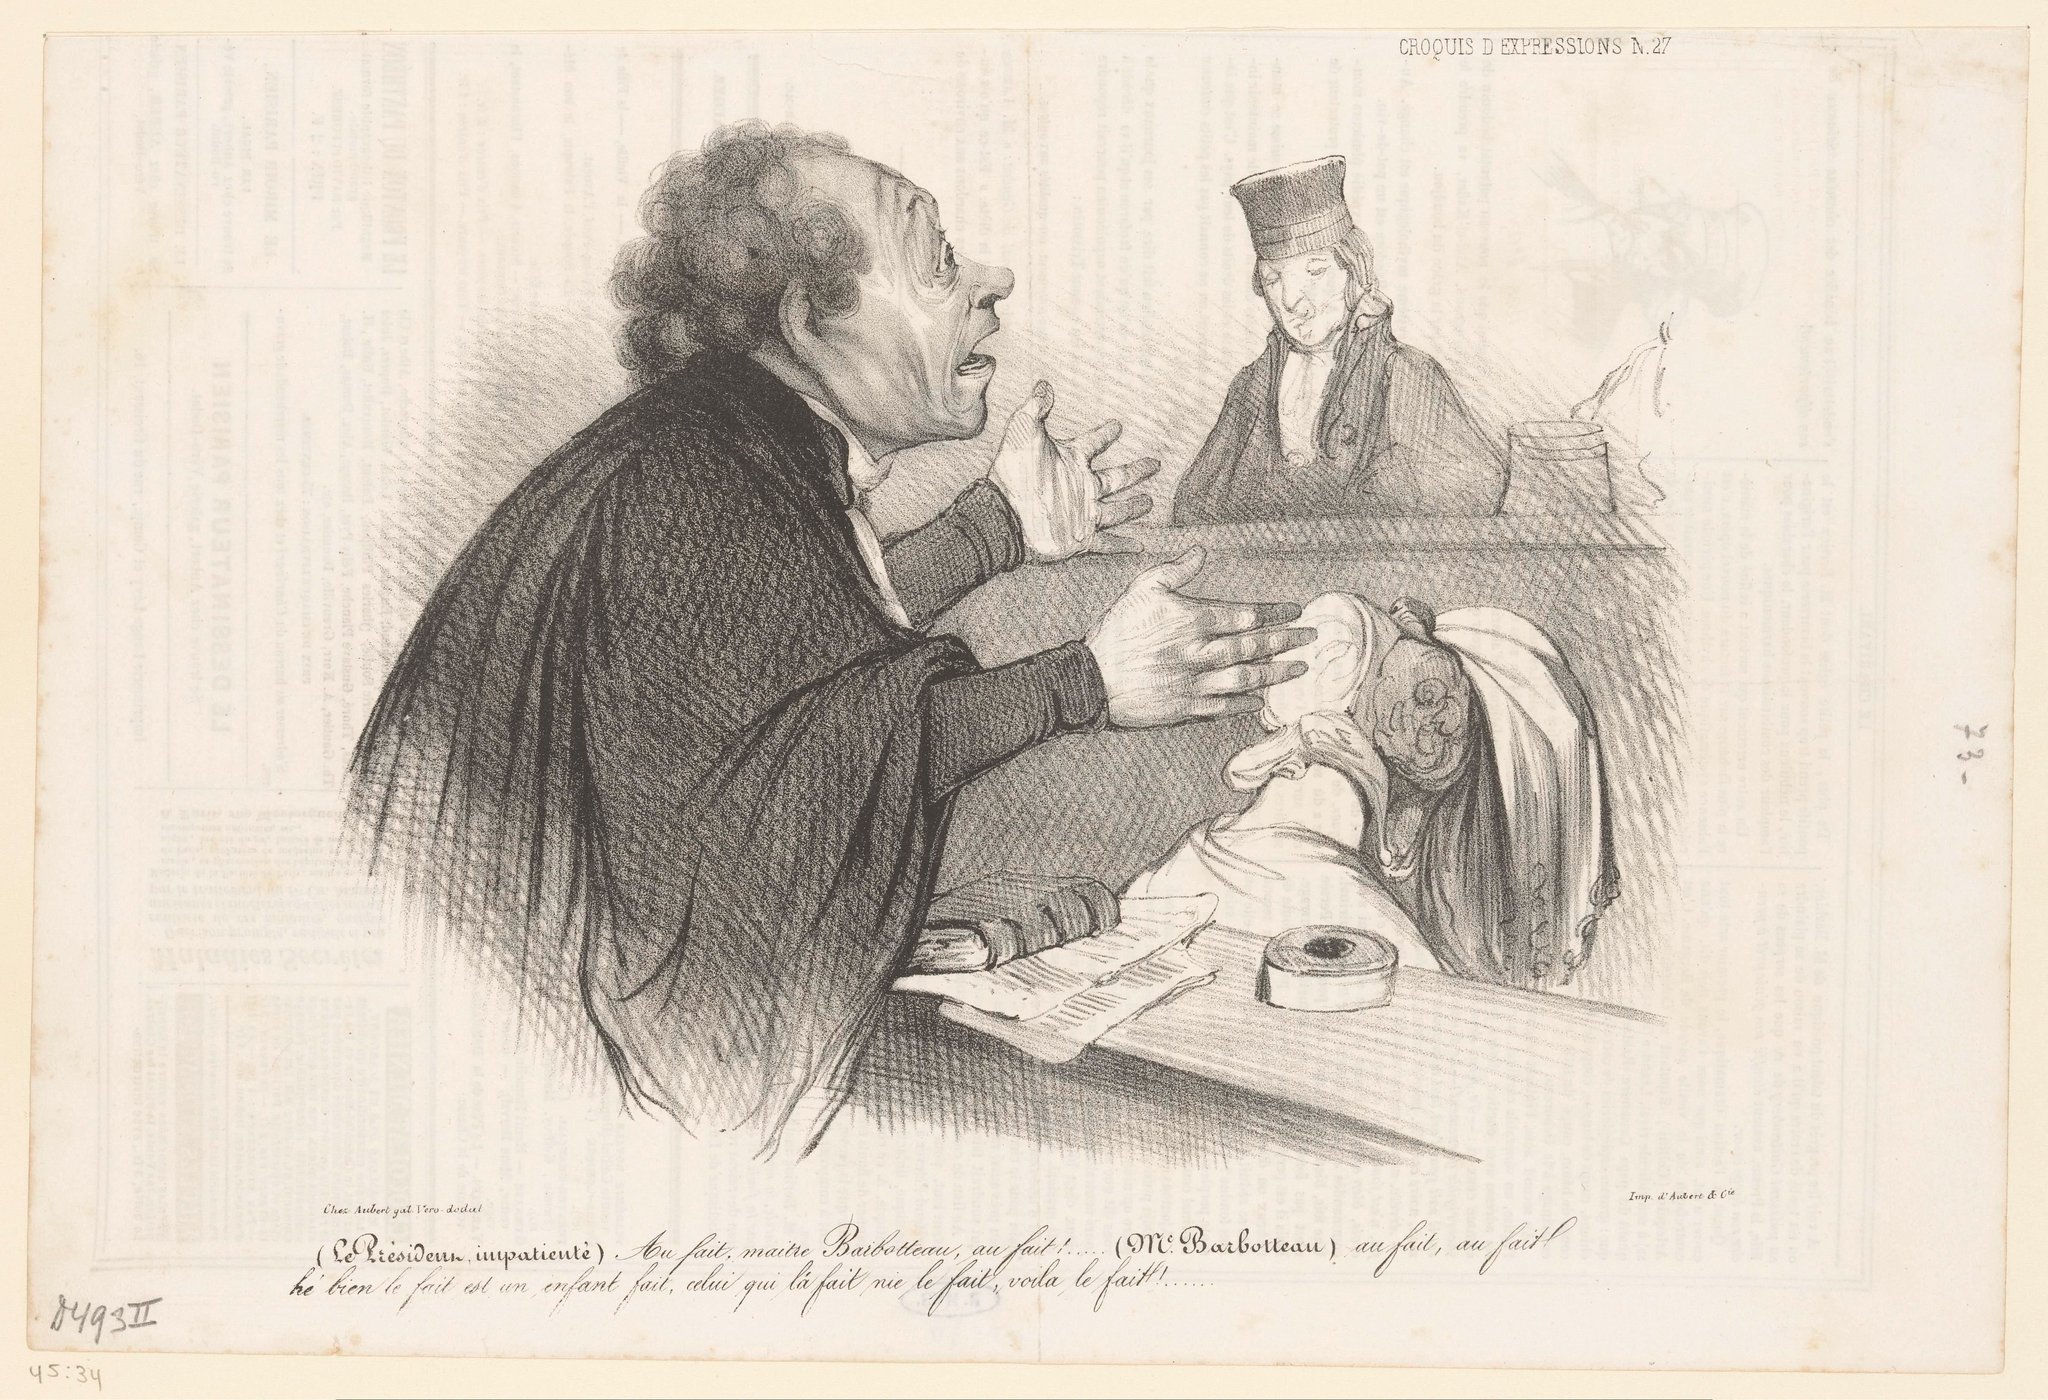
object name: cartoon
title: Gezichtsuitdrukkingen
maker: honoré daumier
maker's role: draughtsman, painter, print maker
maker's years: 1808-1879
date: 1838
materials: paper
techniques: letterpress printing, lithograph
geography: paris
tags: plea, defence, caricatures (human types), court session (court of justice)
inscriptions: collector's mark: Lugt 2228a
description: Prent mogelijk uit: Le Charivari, 12 september 1838.